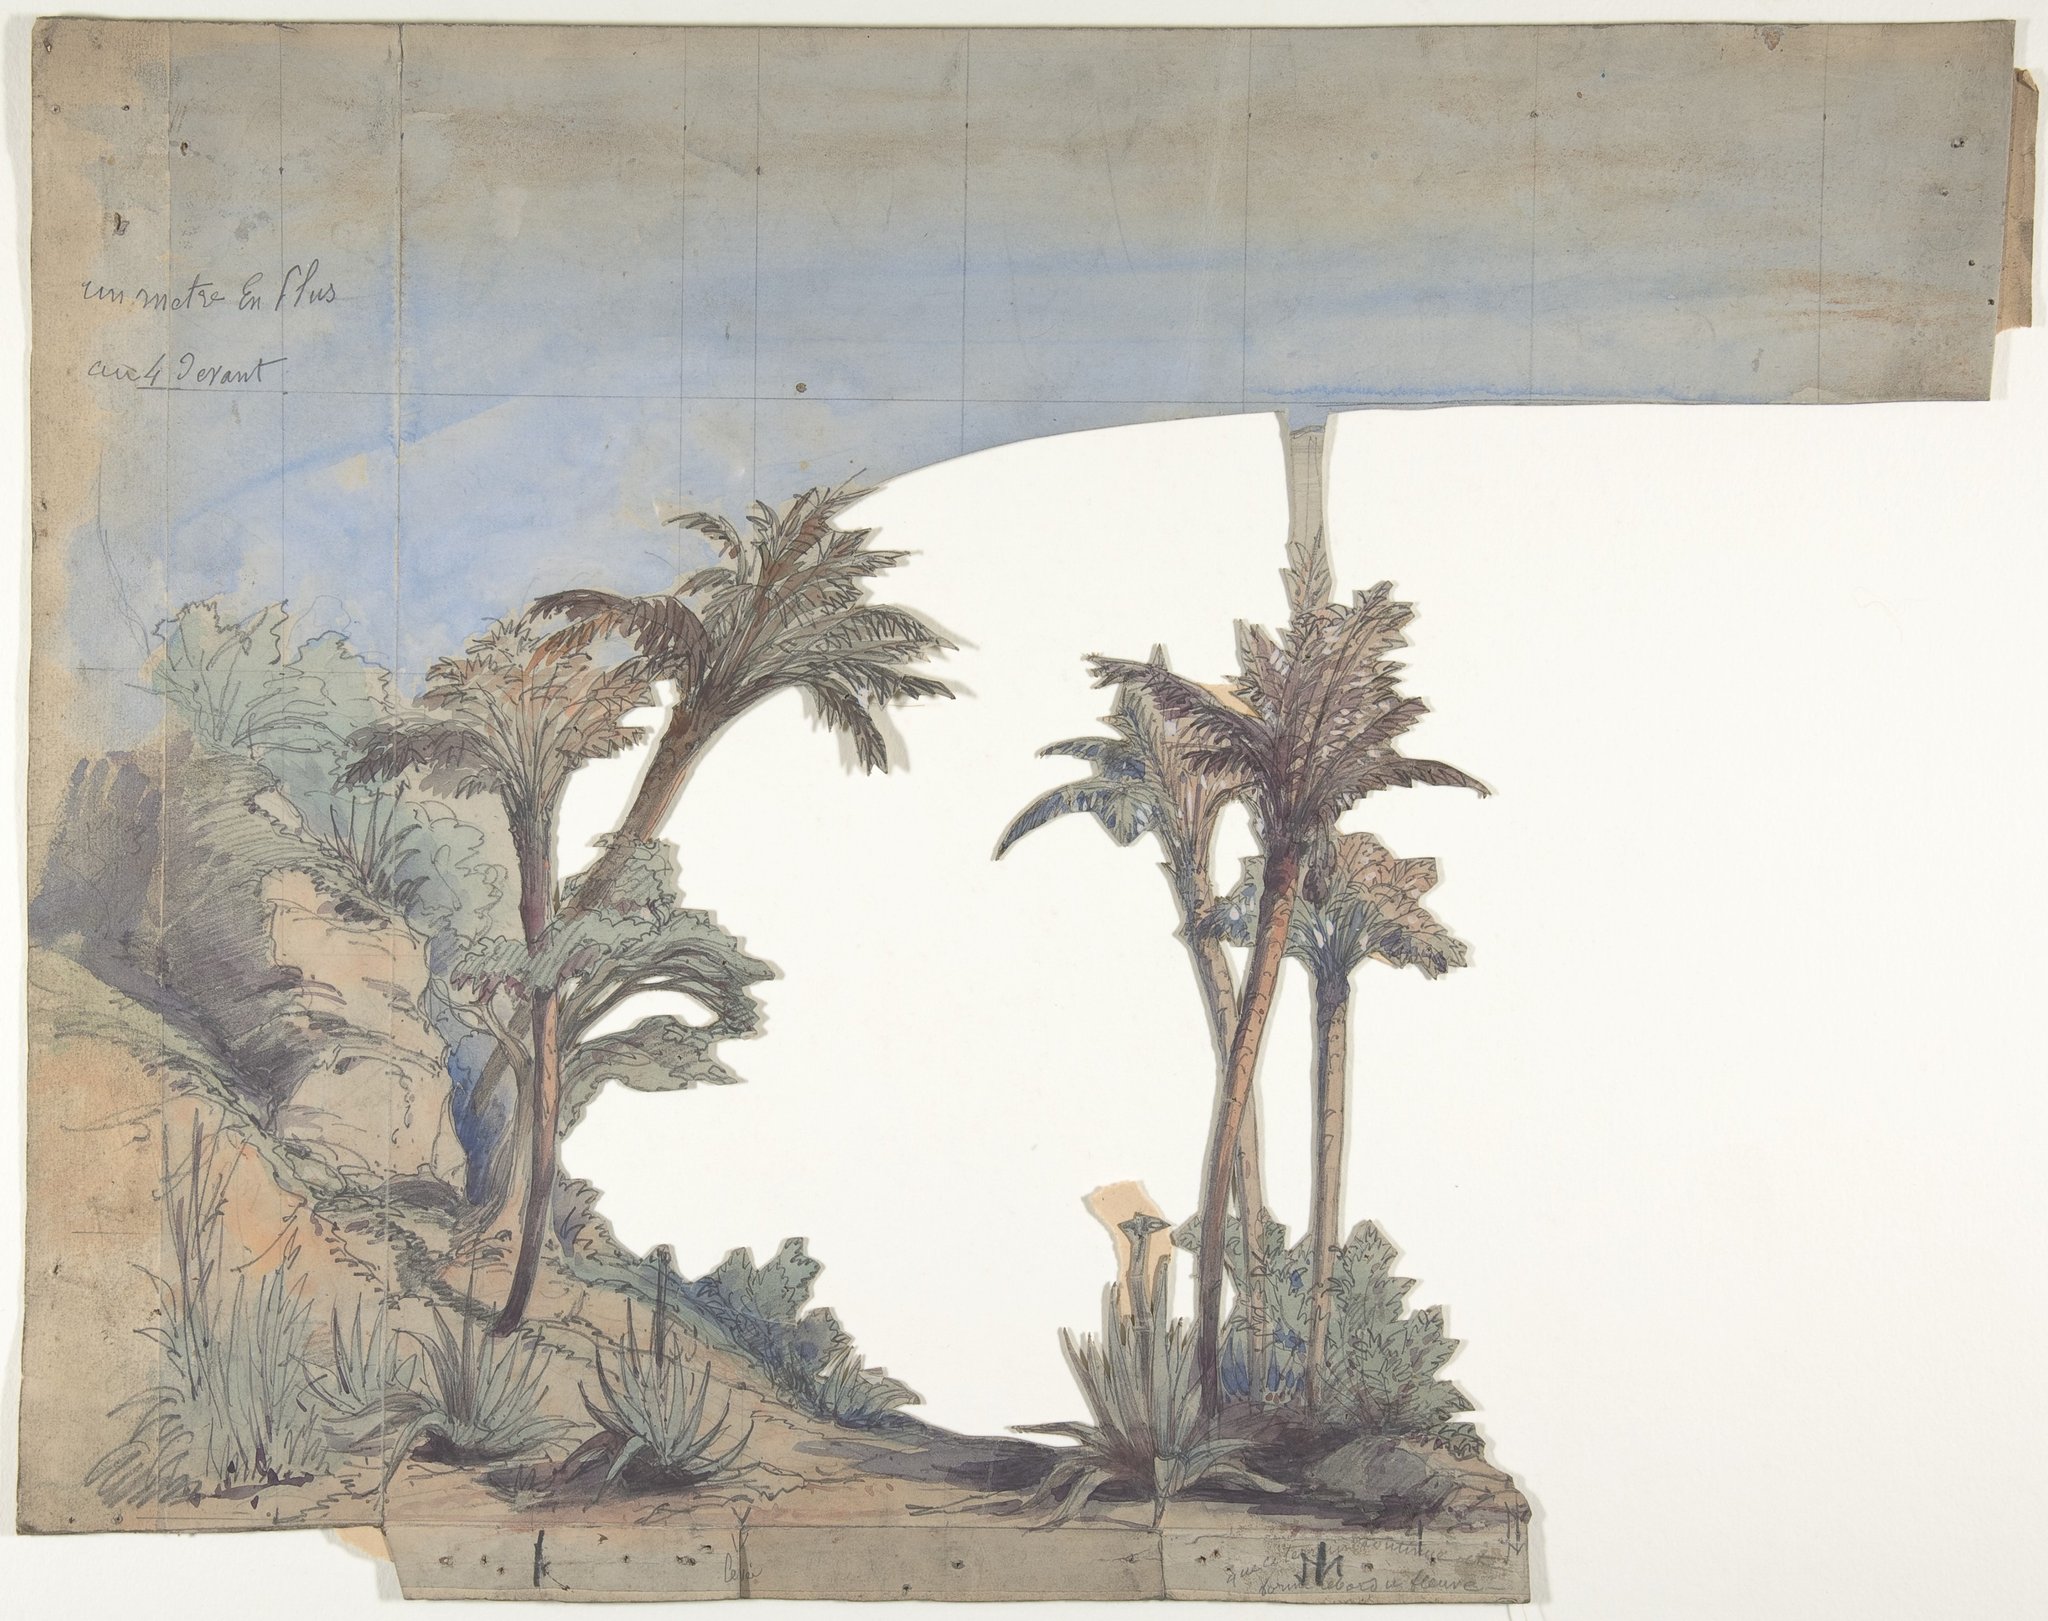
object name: drawing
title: Design for a Stage Set at the Opéra, Paris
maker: eugène cicéri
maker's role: artist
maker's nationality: french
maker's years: 1813-1890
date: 1828-1890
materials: graphite, watercolor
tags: trees,stage design